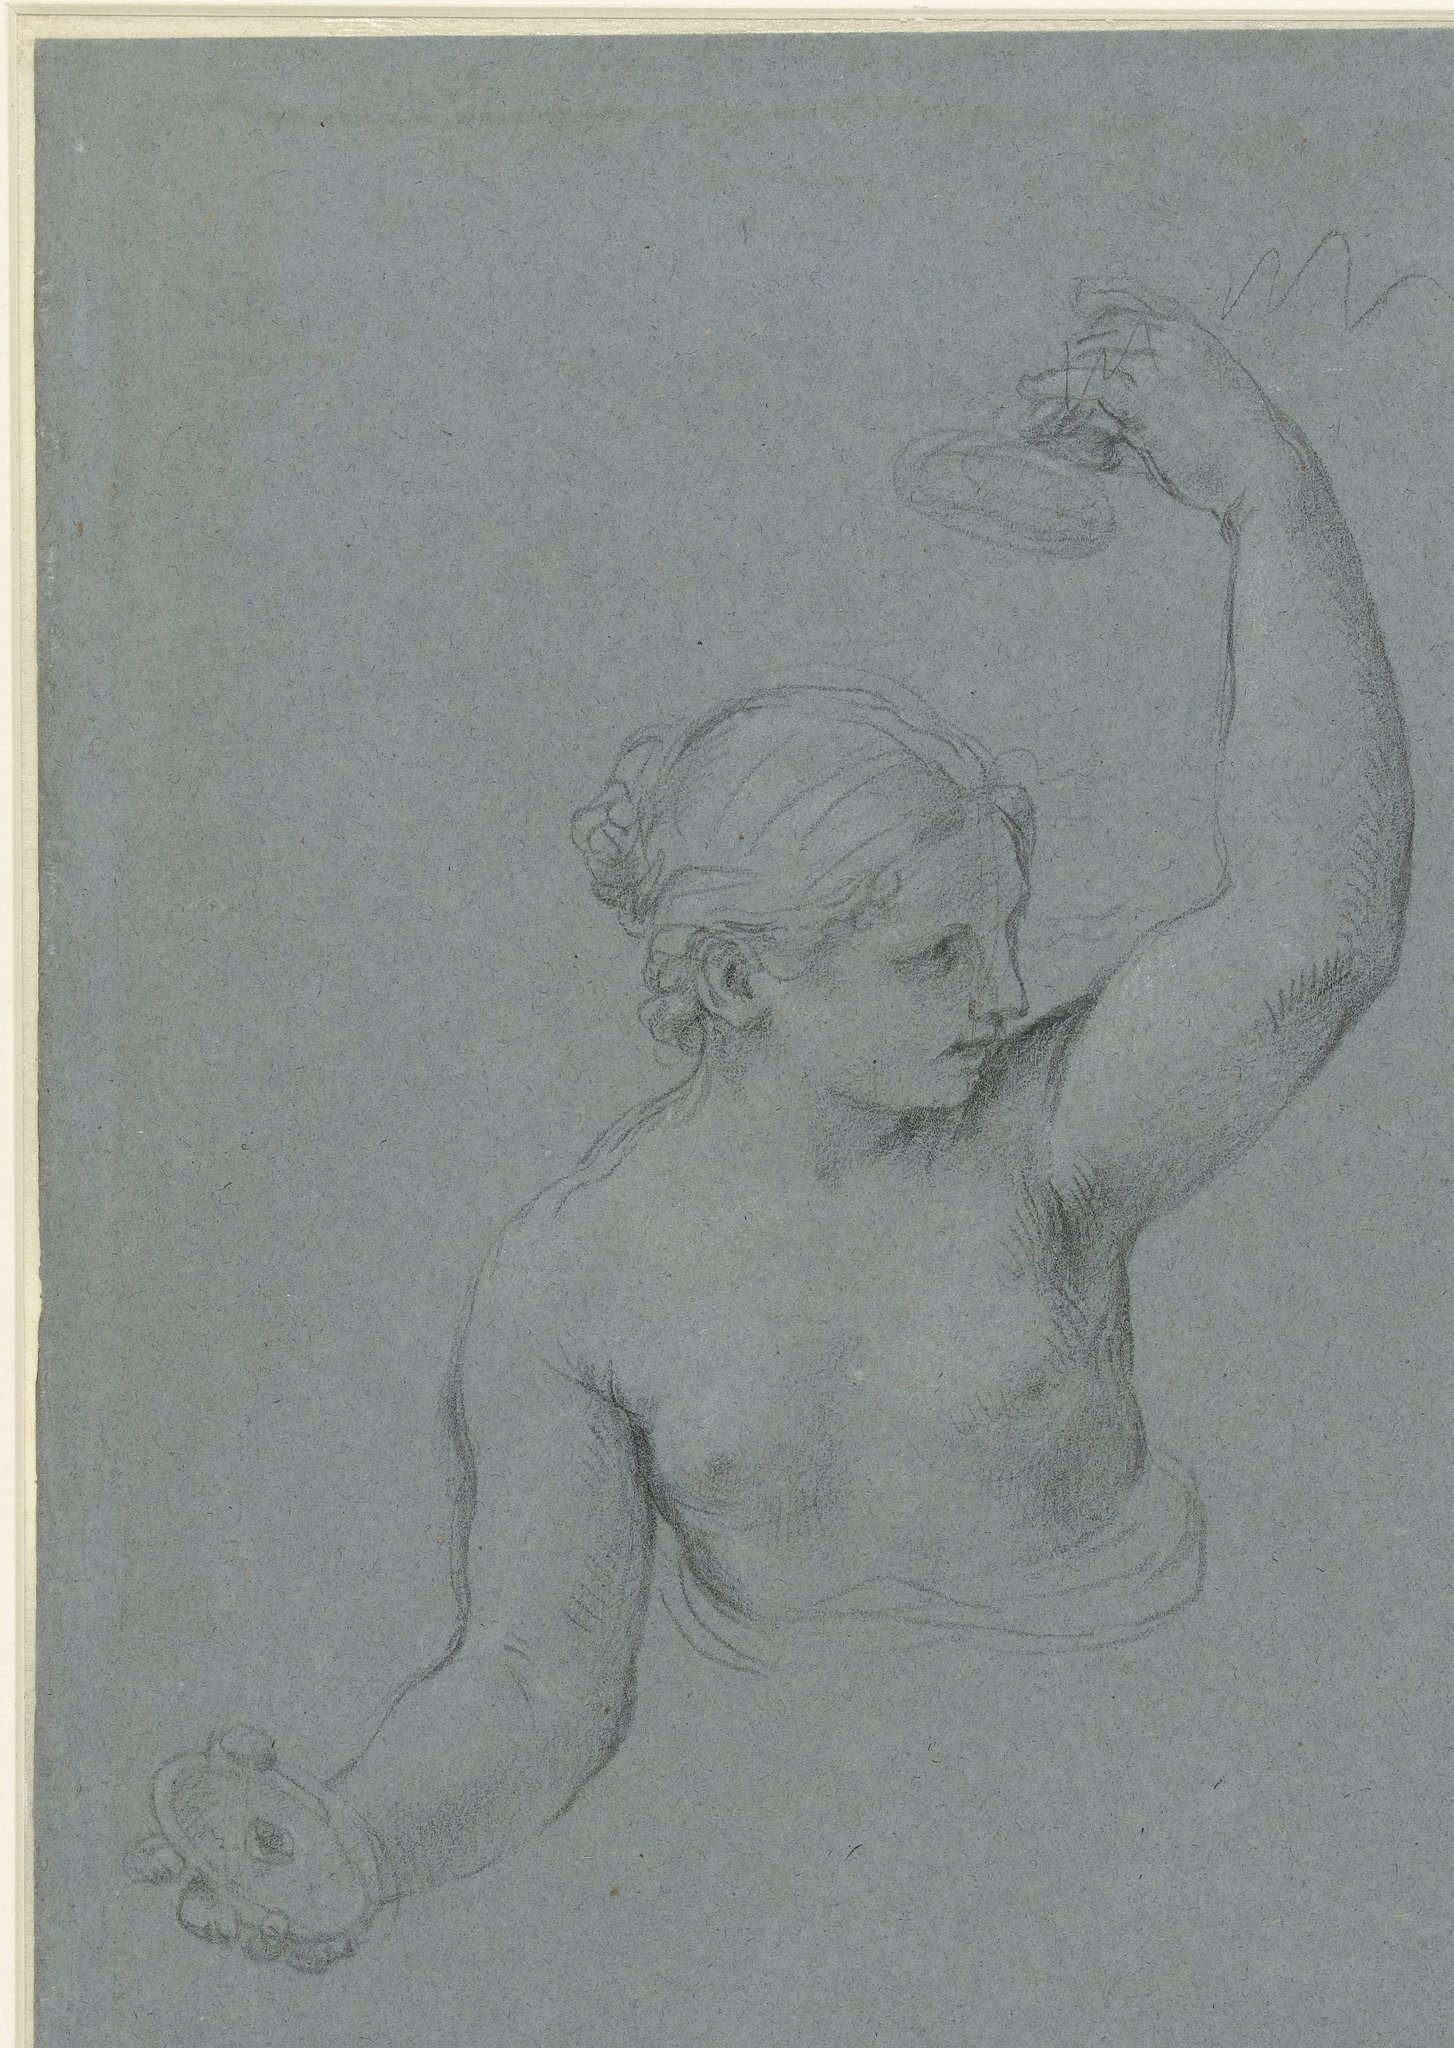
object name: drawing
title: Bacchante met bekkens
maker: Anonymous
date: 1635-1763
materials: chalk, paper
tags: maenad(s), female bacchant(es)